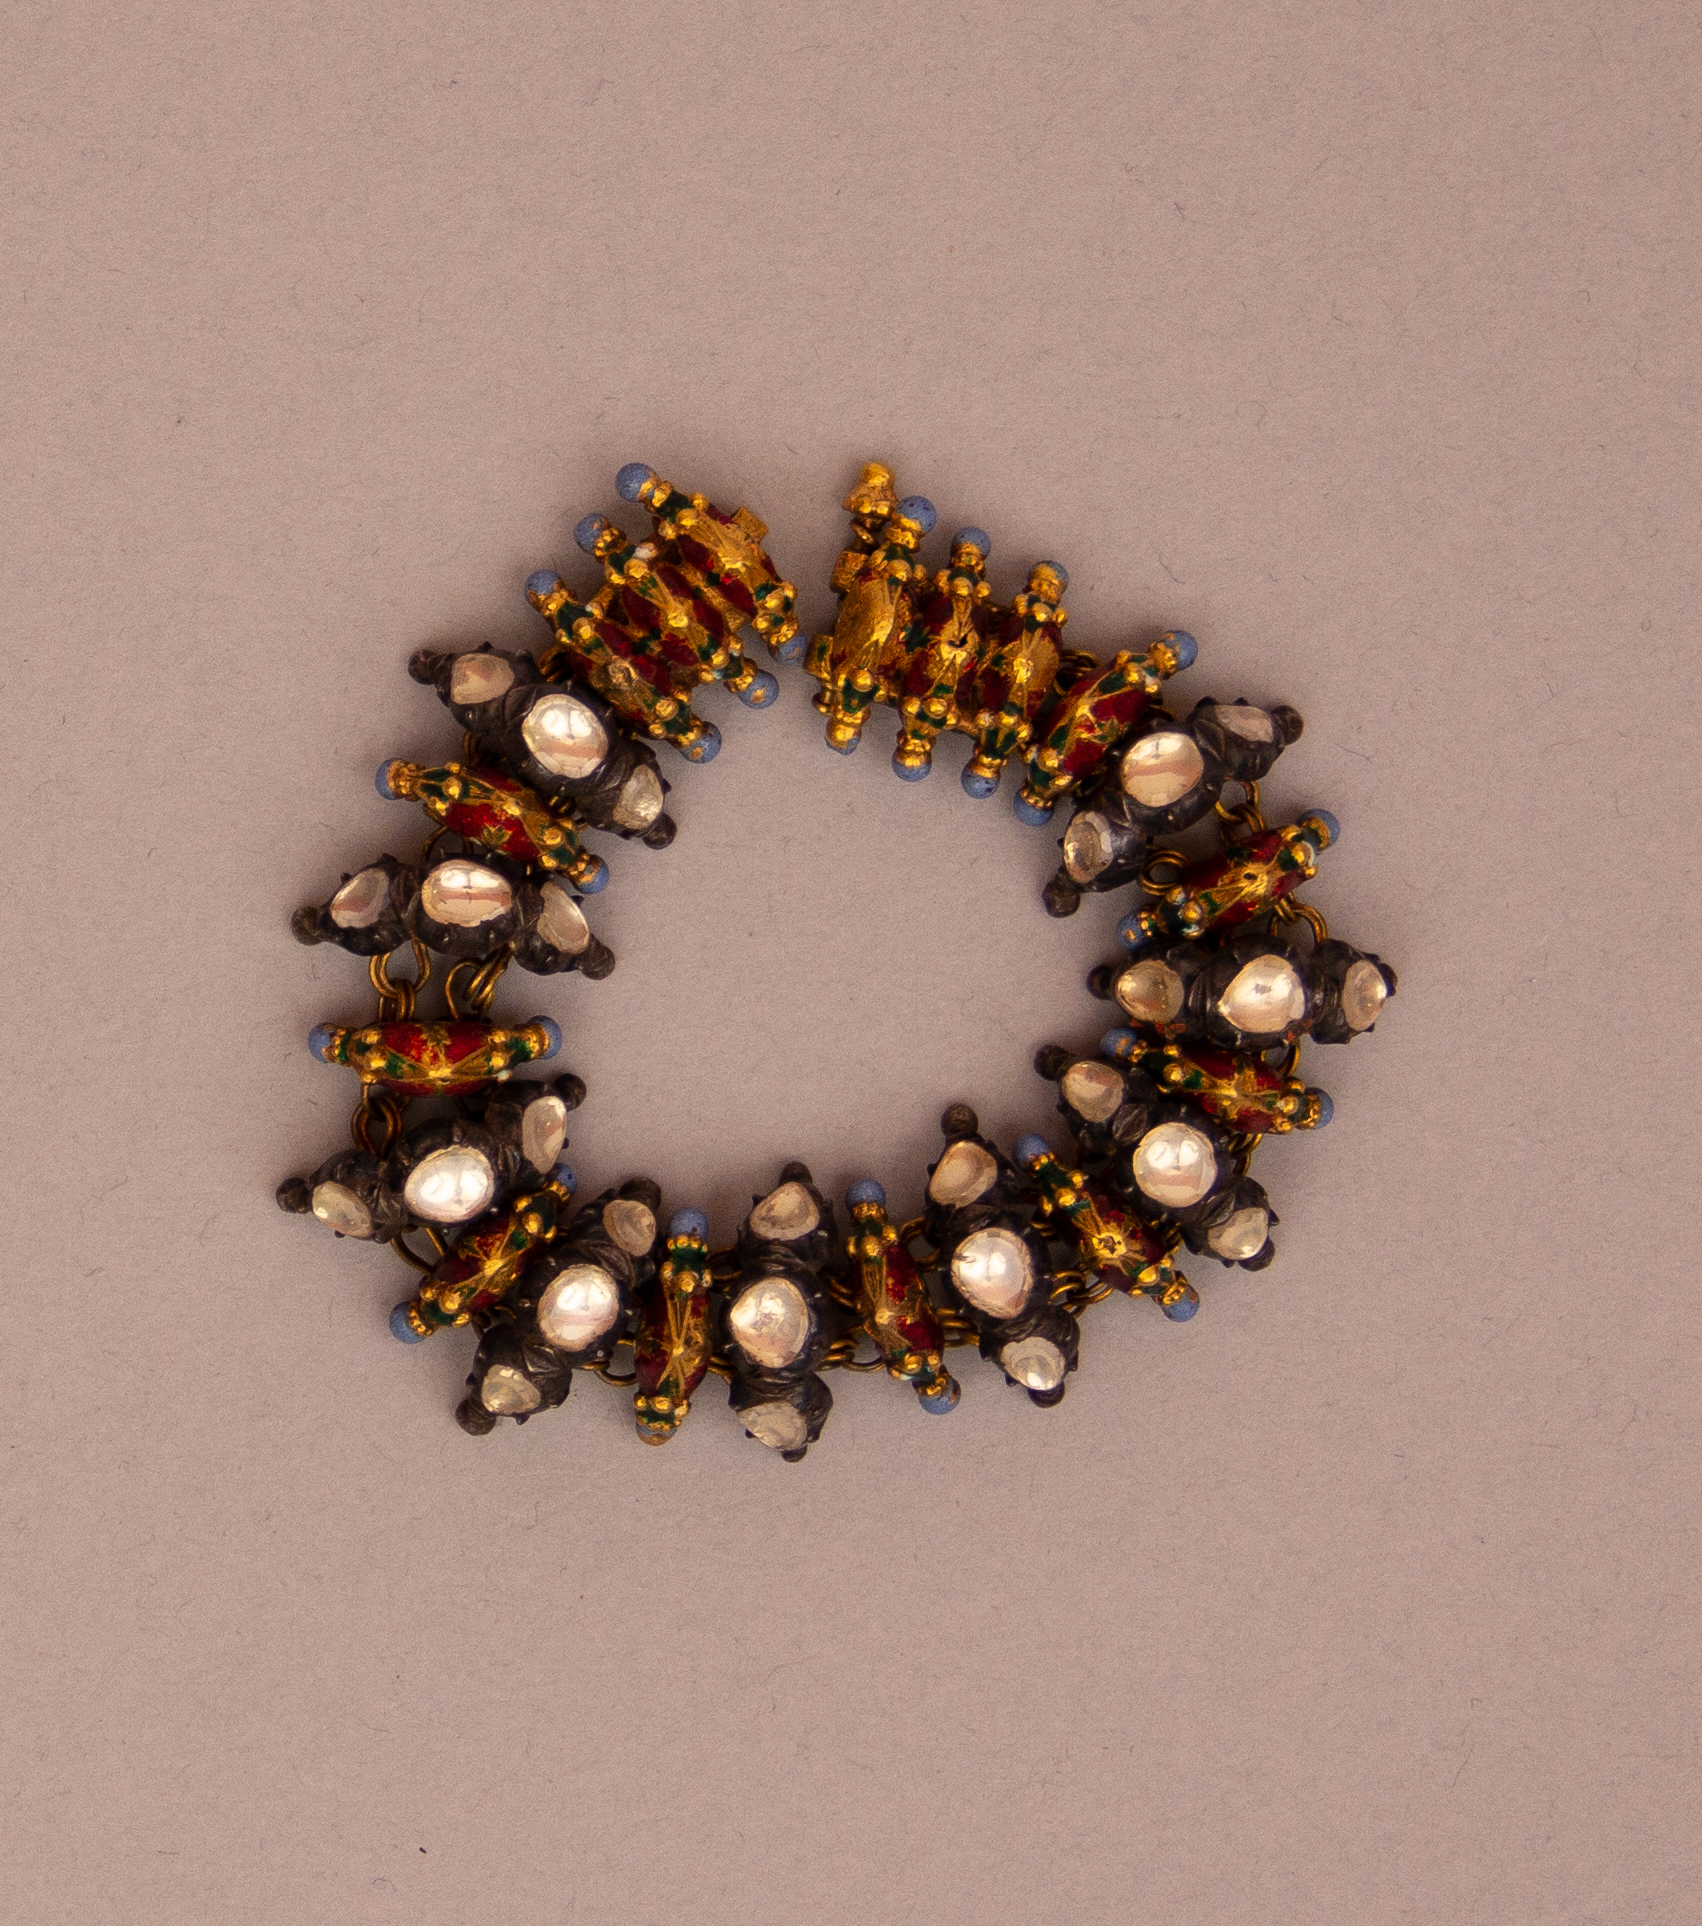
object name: bracelet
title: Bracelet, One of a Pair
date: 1601-1900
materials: gold, silver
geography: india